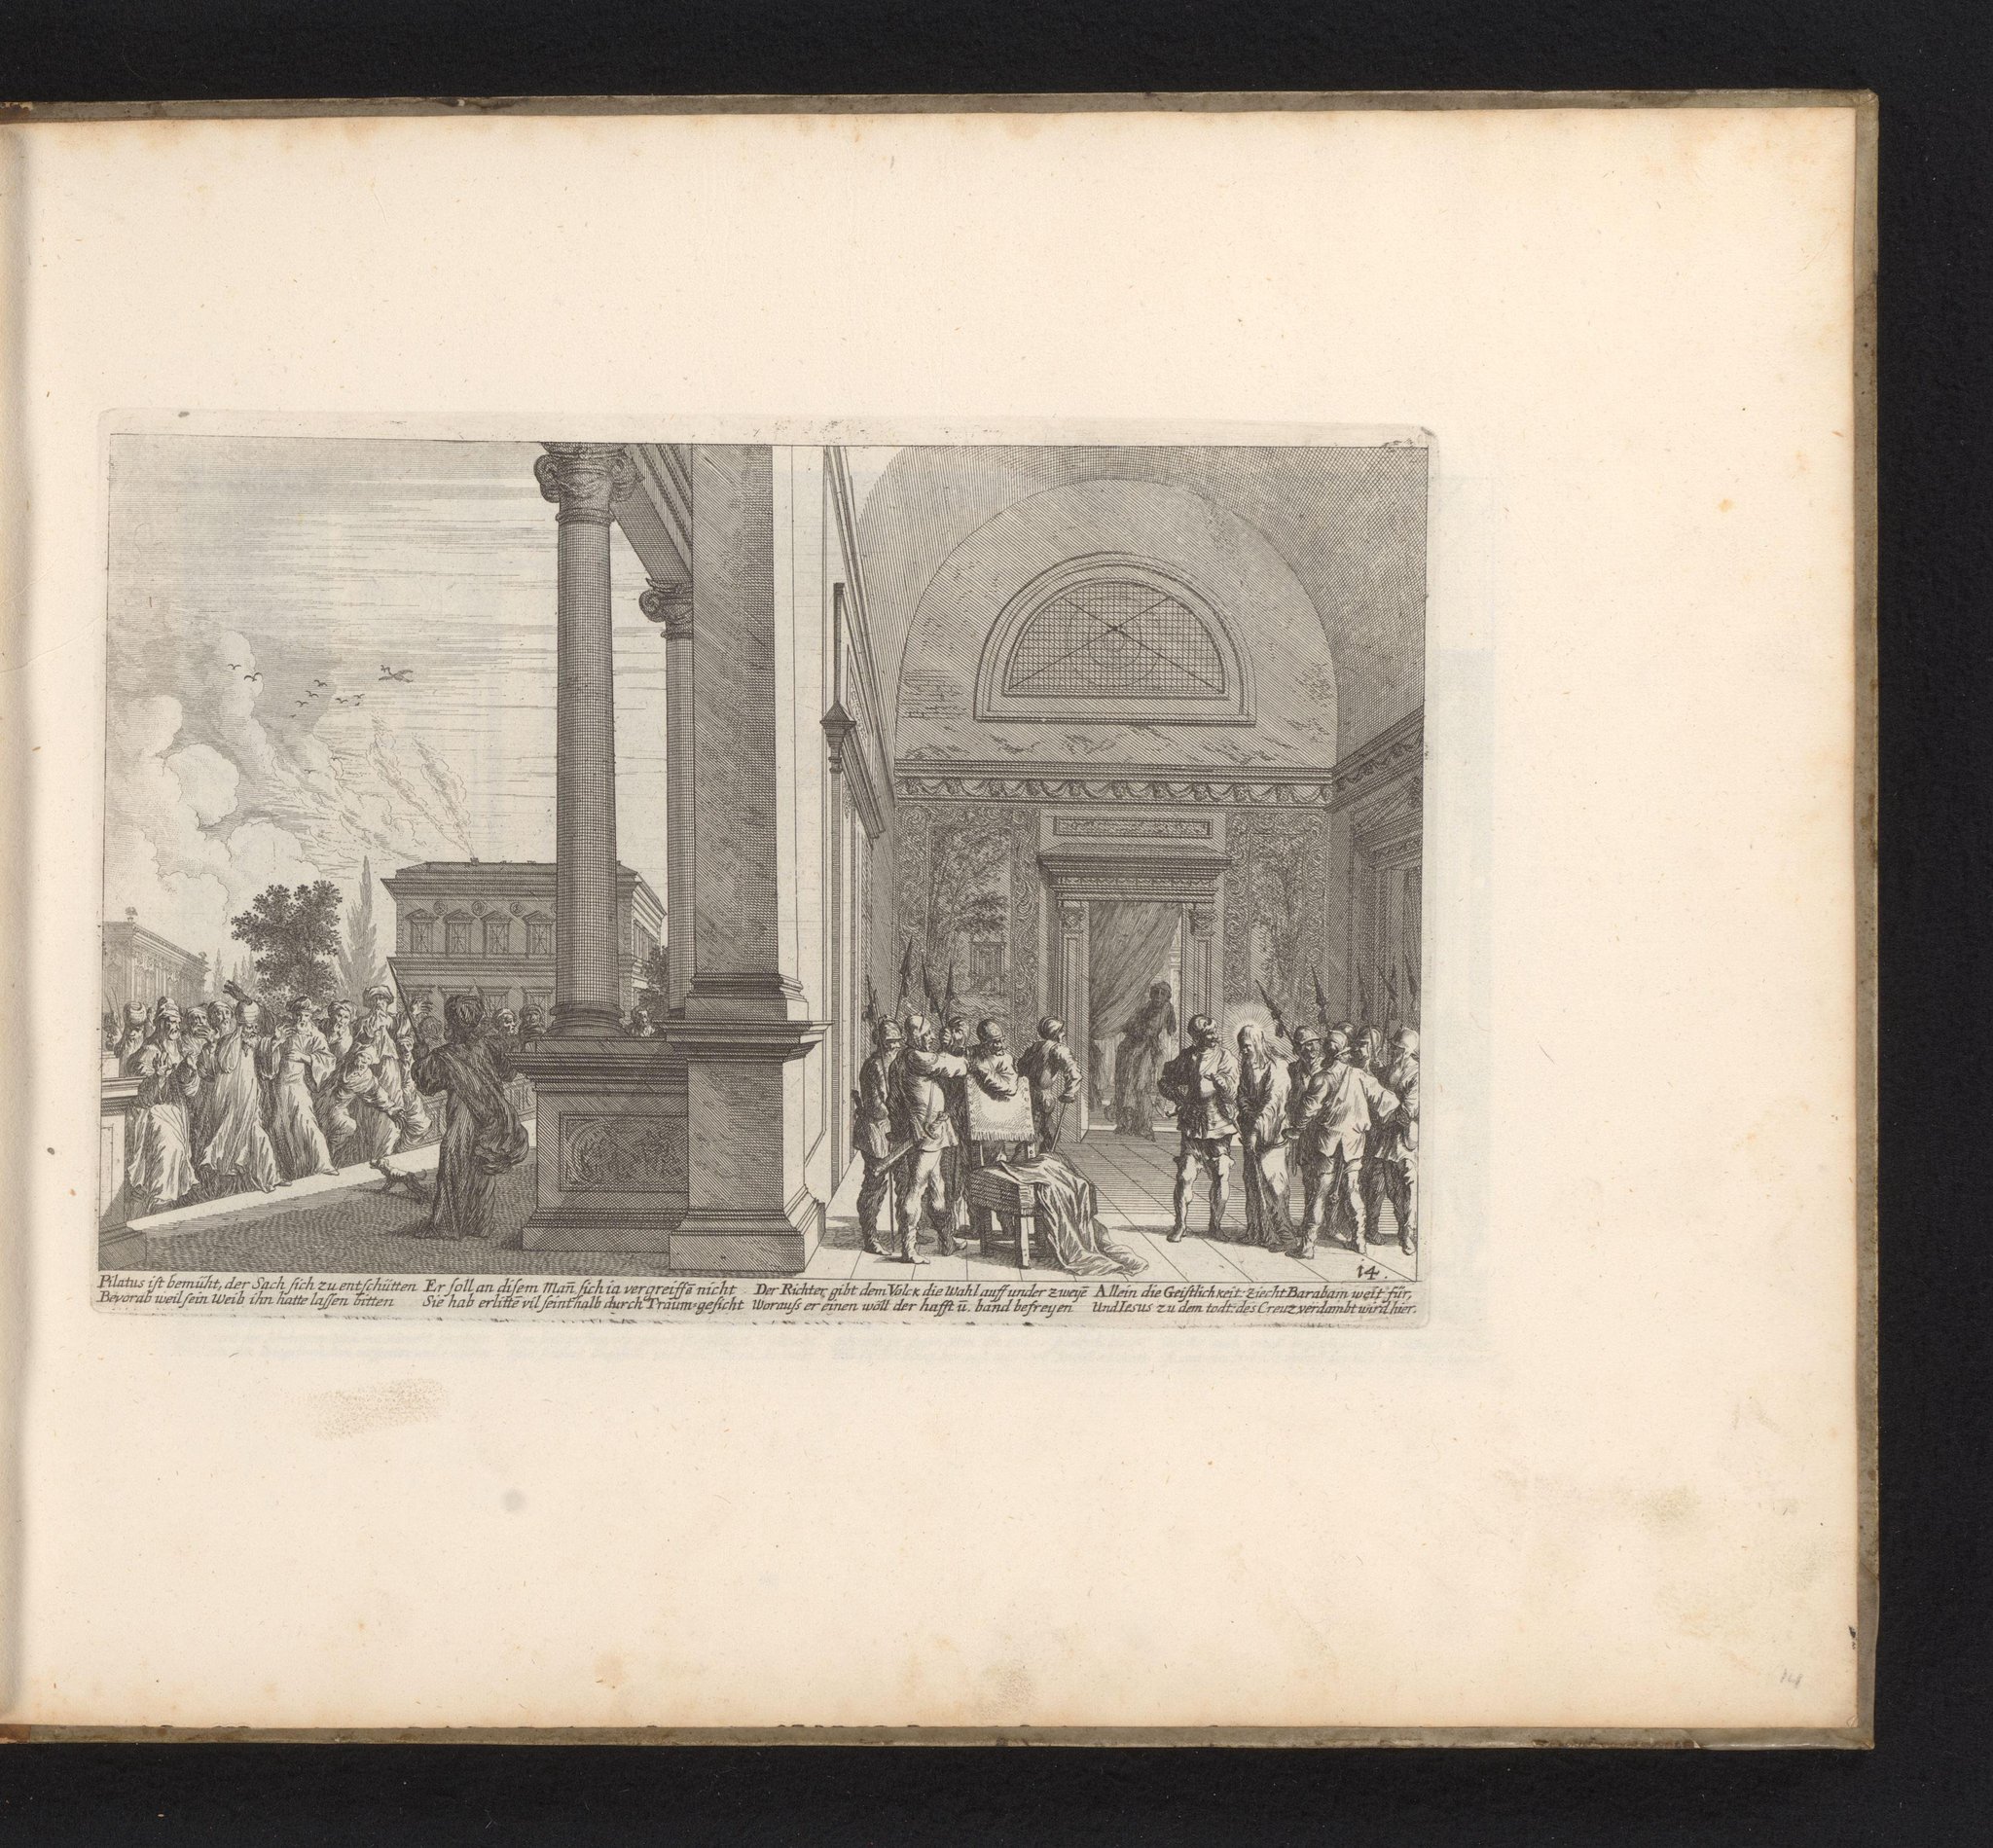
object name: album leaf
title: Pilatus gewaarschuwd door zijn vrouw laat het volk kiezen tussen Christus en Barabbas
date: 1670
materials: paper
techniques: etching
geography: augsburg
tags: choice between christ and barabbas, pilate's wife (or a messenger) warns him of a dream she had about christ, pilate in debate with the jews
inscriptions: collector's mark: Lugt 2228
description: Tekst in het Duits in de ondermarge. Rechtsonder genummerd: 14. Prent maakt deel uit van een album.